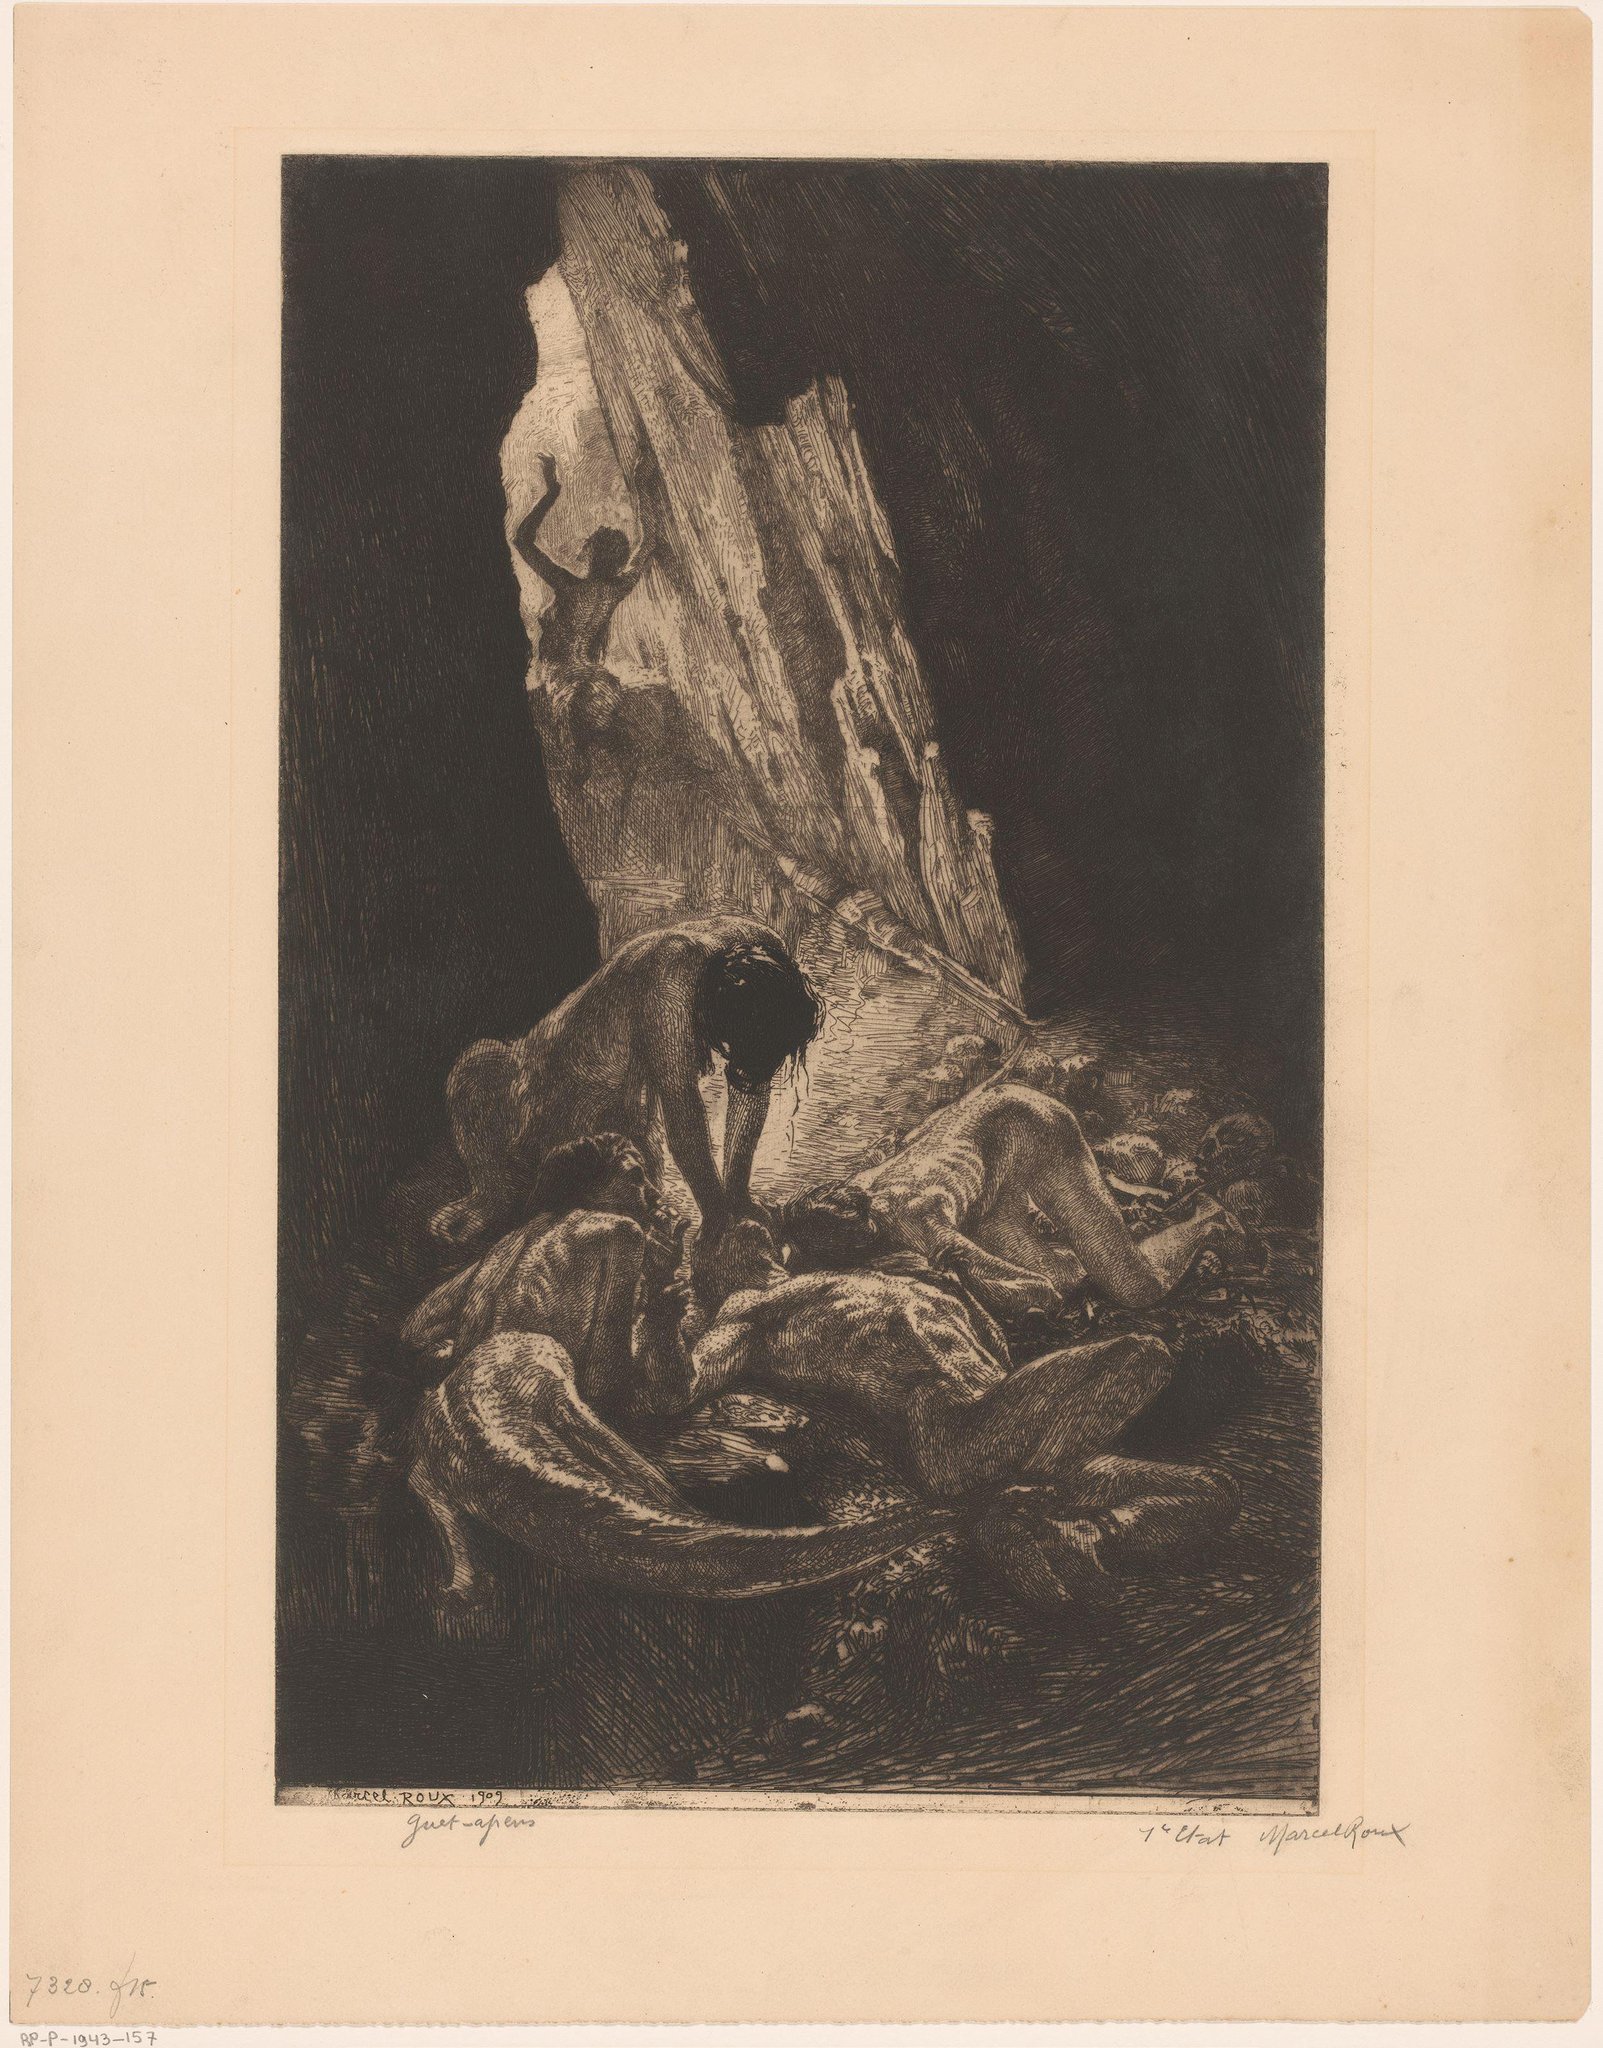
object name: print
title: Guet-apens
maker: marcel roux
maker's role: print maker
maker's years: 1878-1922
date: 1909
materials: paper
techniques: drypoint, etching, intaglio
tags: merman, (corpse of) man eaten by animals, cave, grotto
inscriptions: collector's mark: Lugt 2113, collector's mark: Lugt 2228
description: Drie naakte mensachtige wezens, waarvan één met een vissenstaart, buigen zich over het lichaam van een man die op de grond ligt. Op de achtergrond staat nog een figuur bij de ingang van de grot.